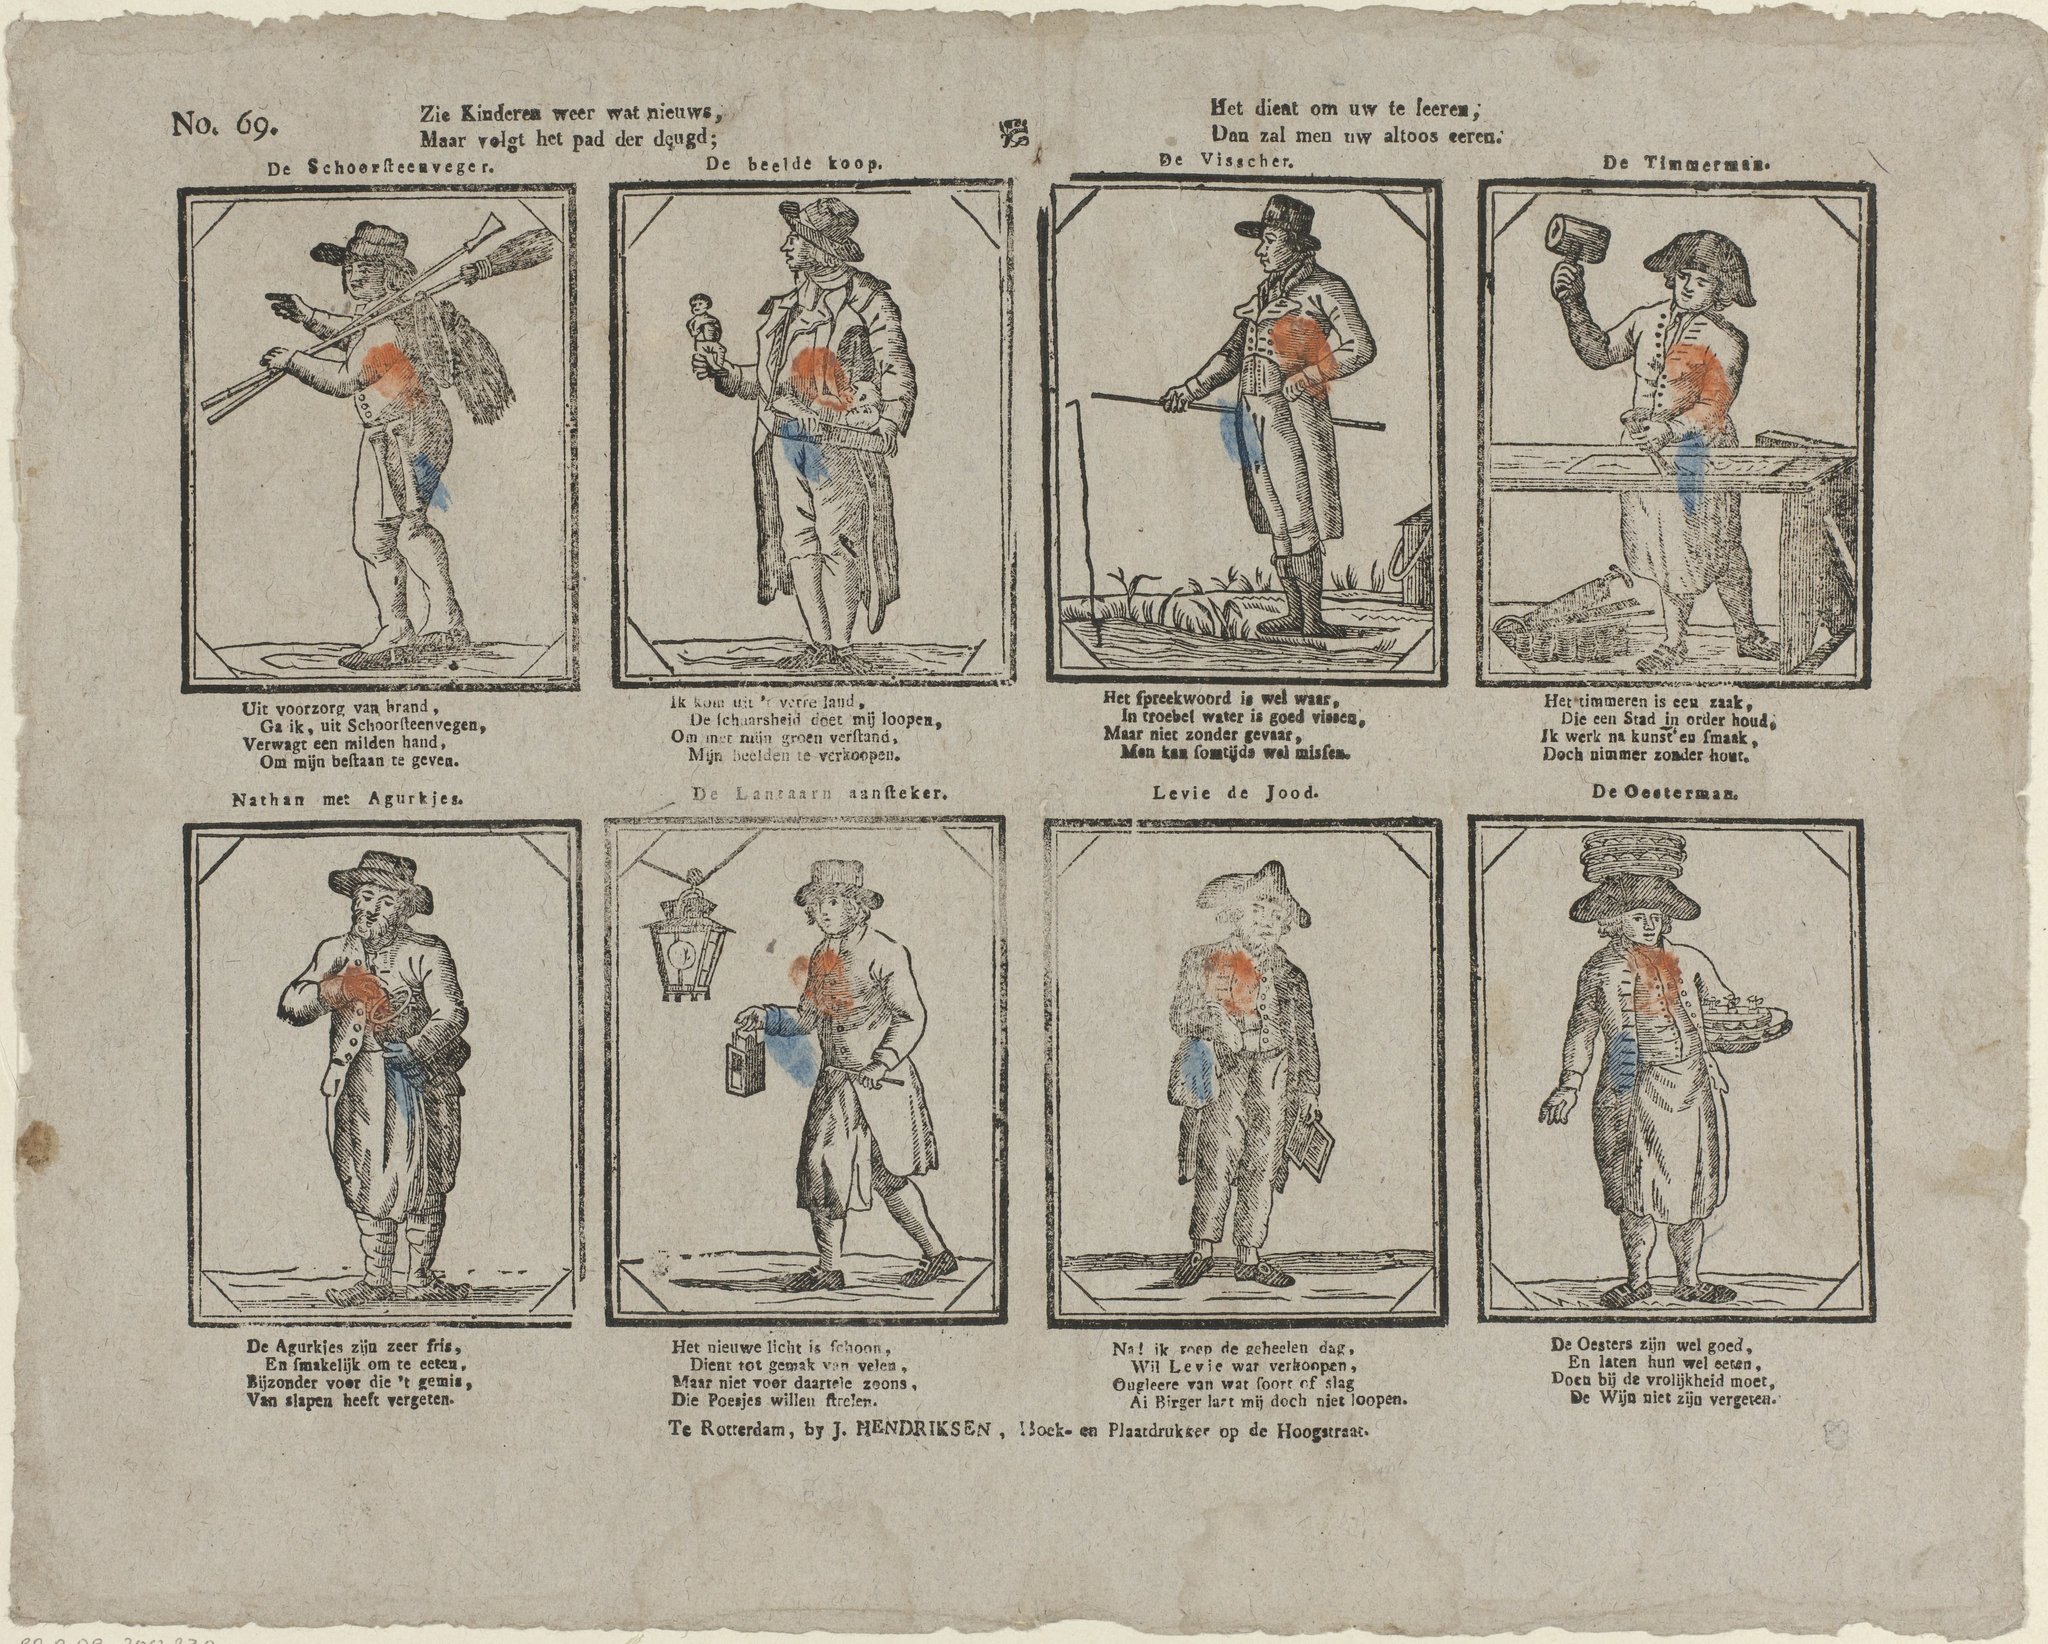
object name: print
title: Zie kinderen weer wat nieuws, / Maar volgt het pad der deugd, / Het dient om uw te leeren, / Dan zal men uw altoos eeren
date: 1781-1828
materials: paper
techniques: colour, letterpress printing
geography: rotterdam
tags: carpenter, street-trader, handicrafts ~ maintenance and repair (with name of trade or profession), fisherman, merchant, salesman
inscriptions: collector's mark: Lugt 2760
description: Blad met 4 voorstellingen van ambachtslieden en beroepen, zoals schoorsteenveger, visser en lantaarnaansteker. Onder elke afbeelding een vierregelig vers. genummerd linksboven: No. 69.